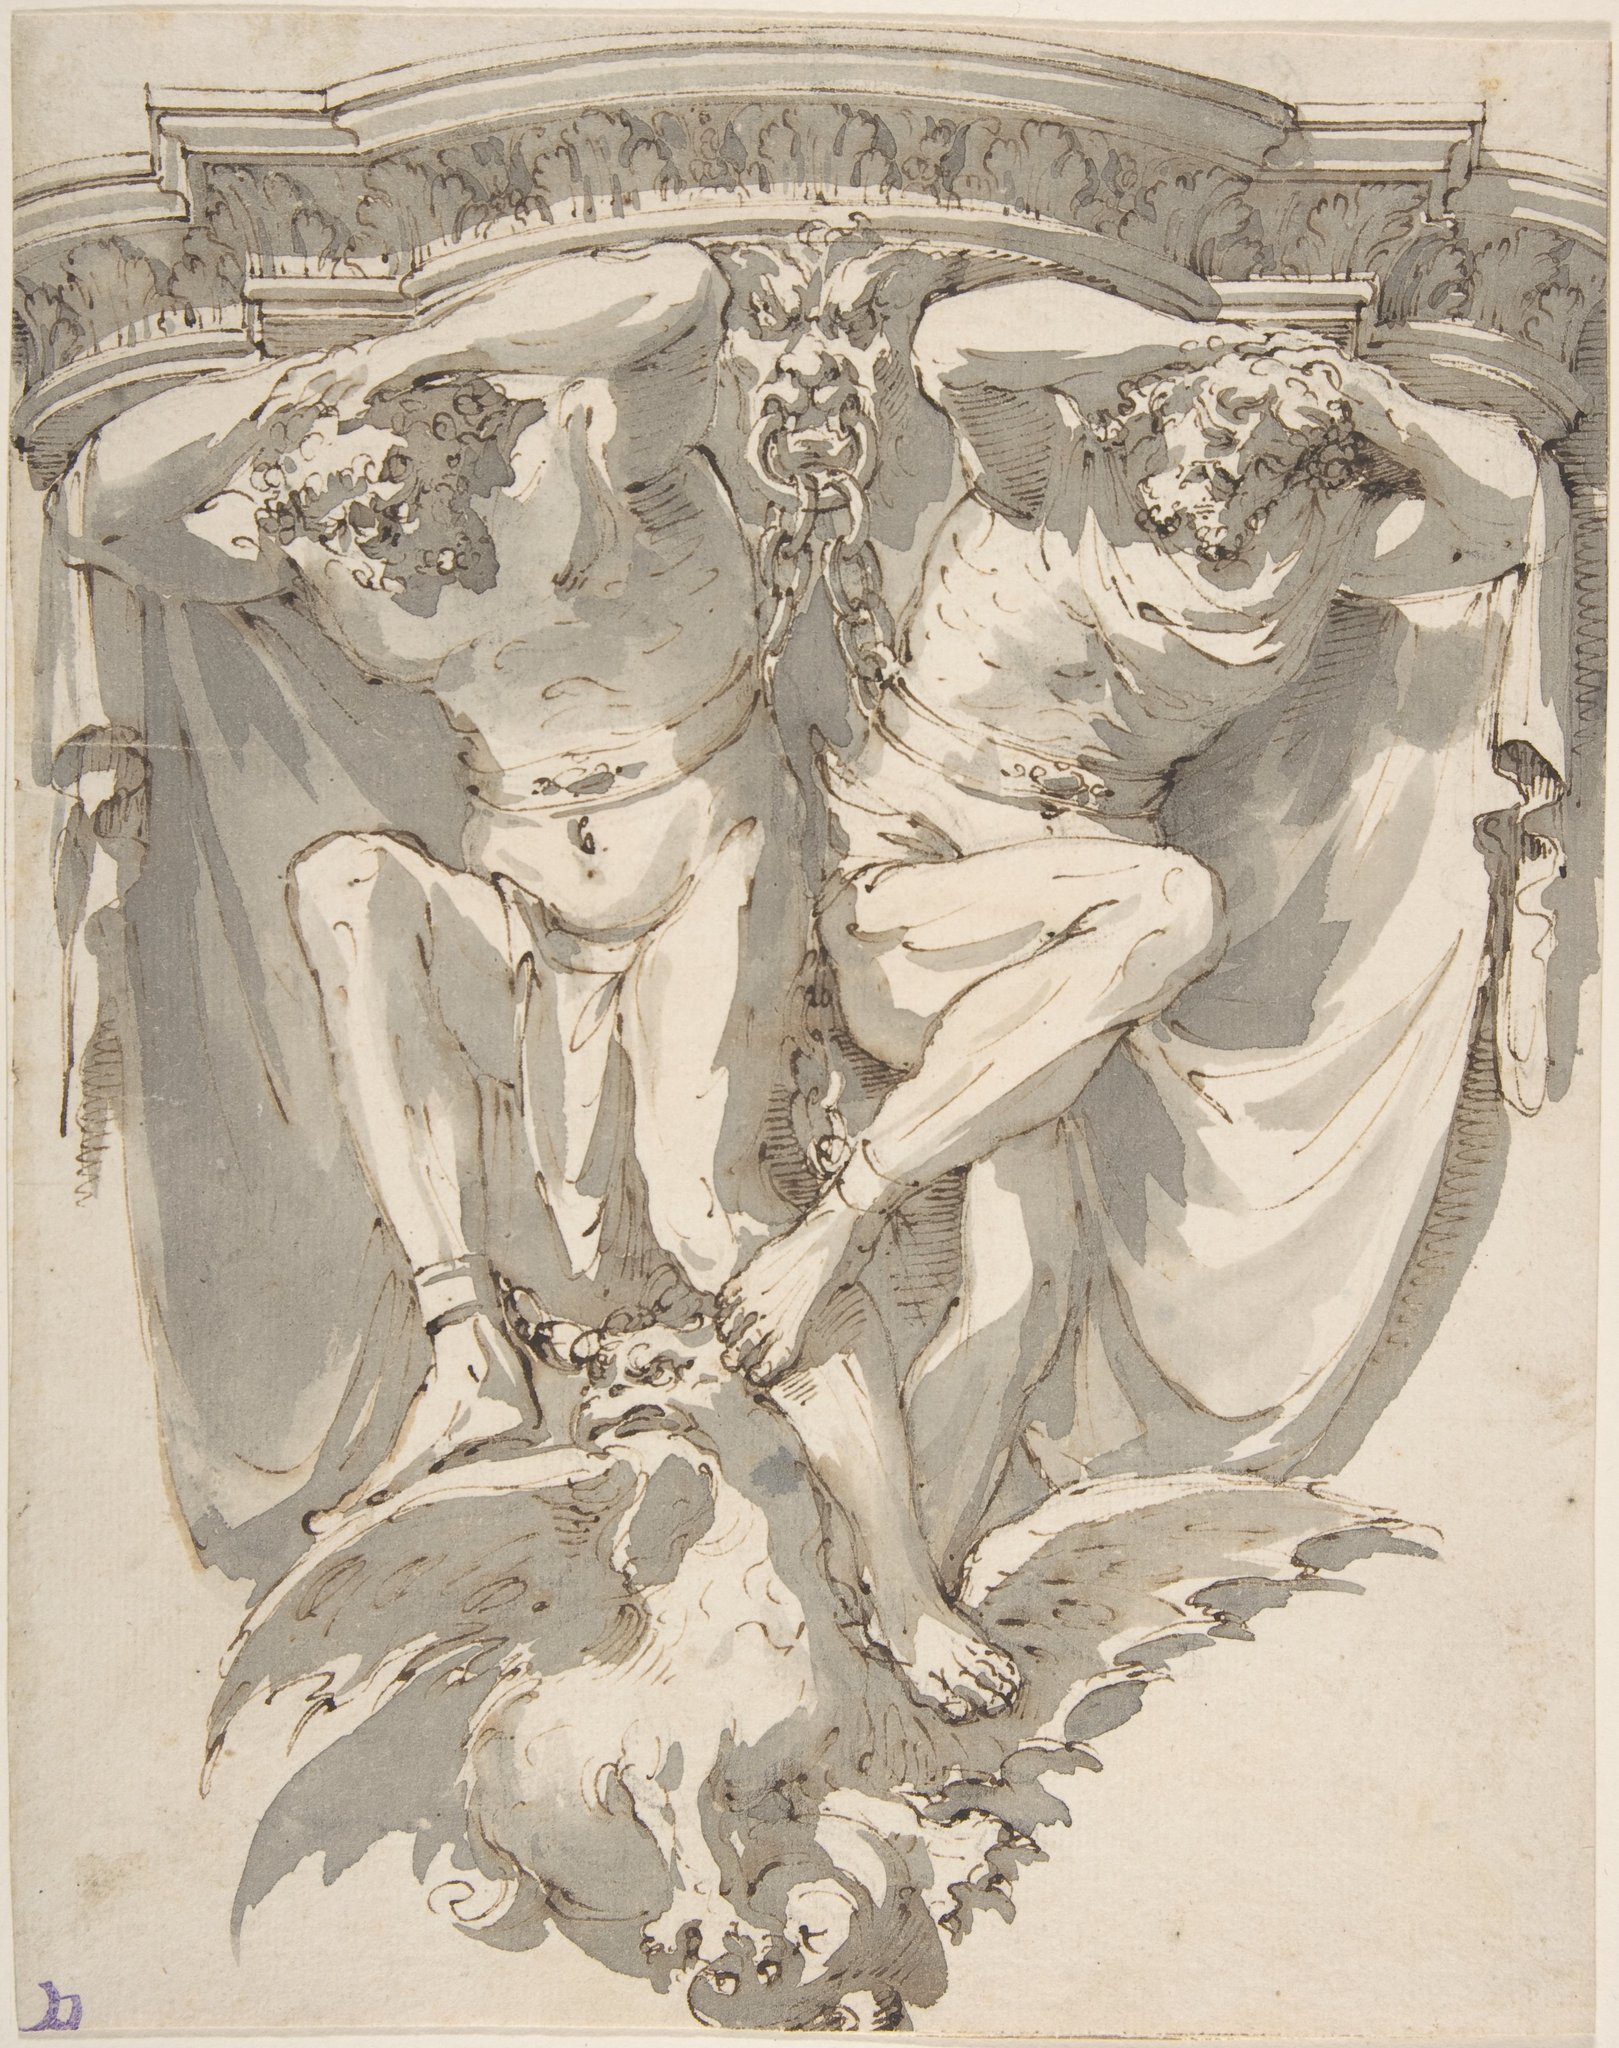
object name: drawing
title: Design for a Decorated Console with Two Slaves on Top of an Eagle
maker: giuseppe bernardino bison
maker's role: artist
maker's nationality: italian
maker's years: 1762-1844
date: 1782-1844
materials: ink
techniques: brush, pen, wash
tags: eagles,men,slaves